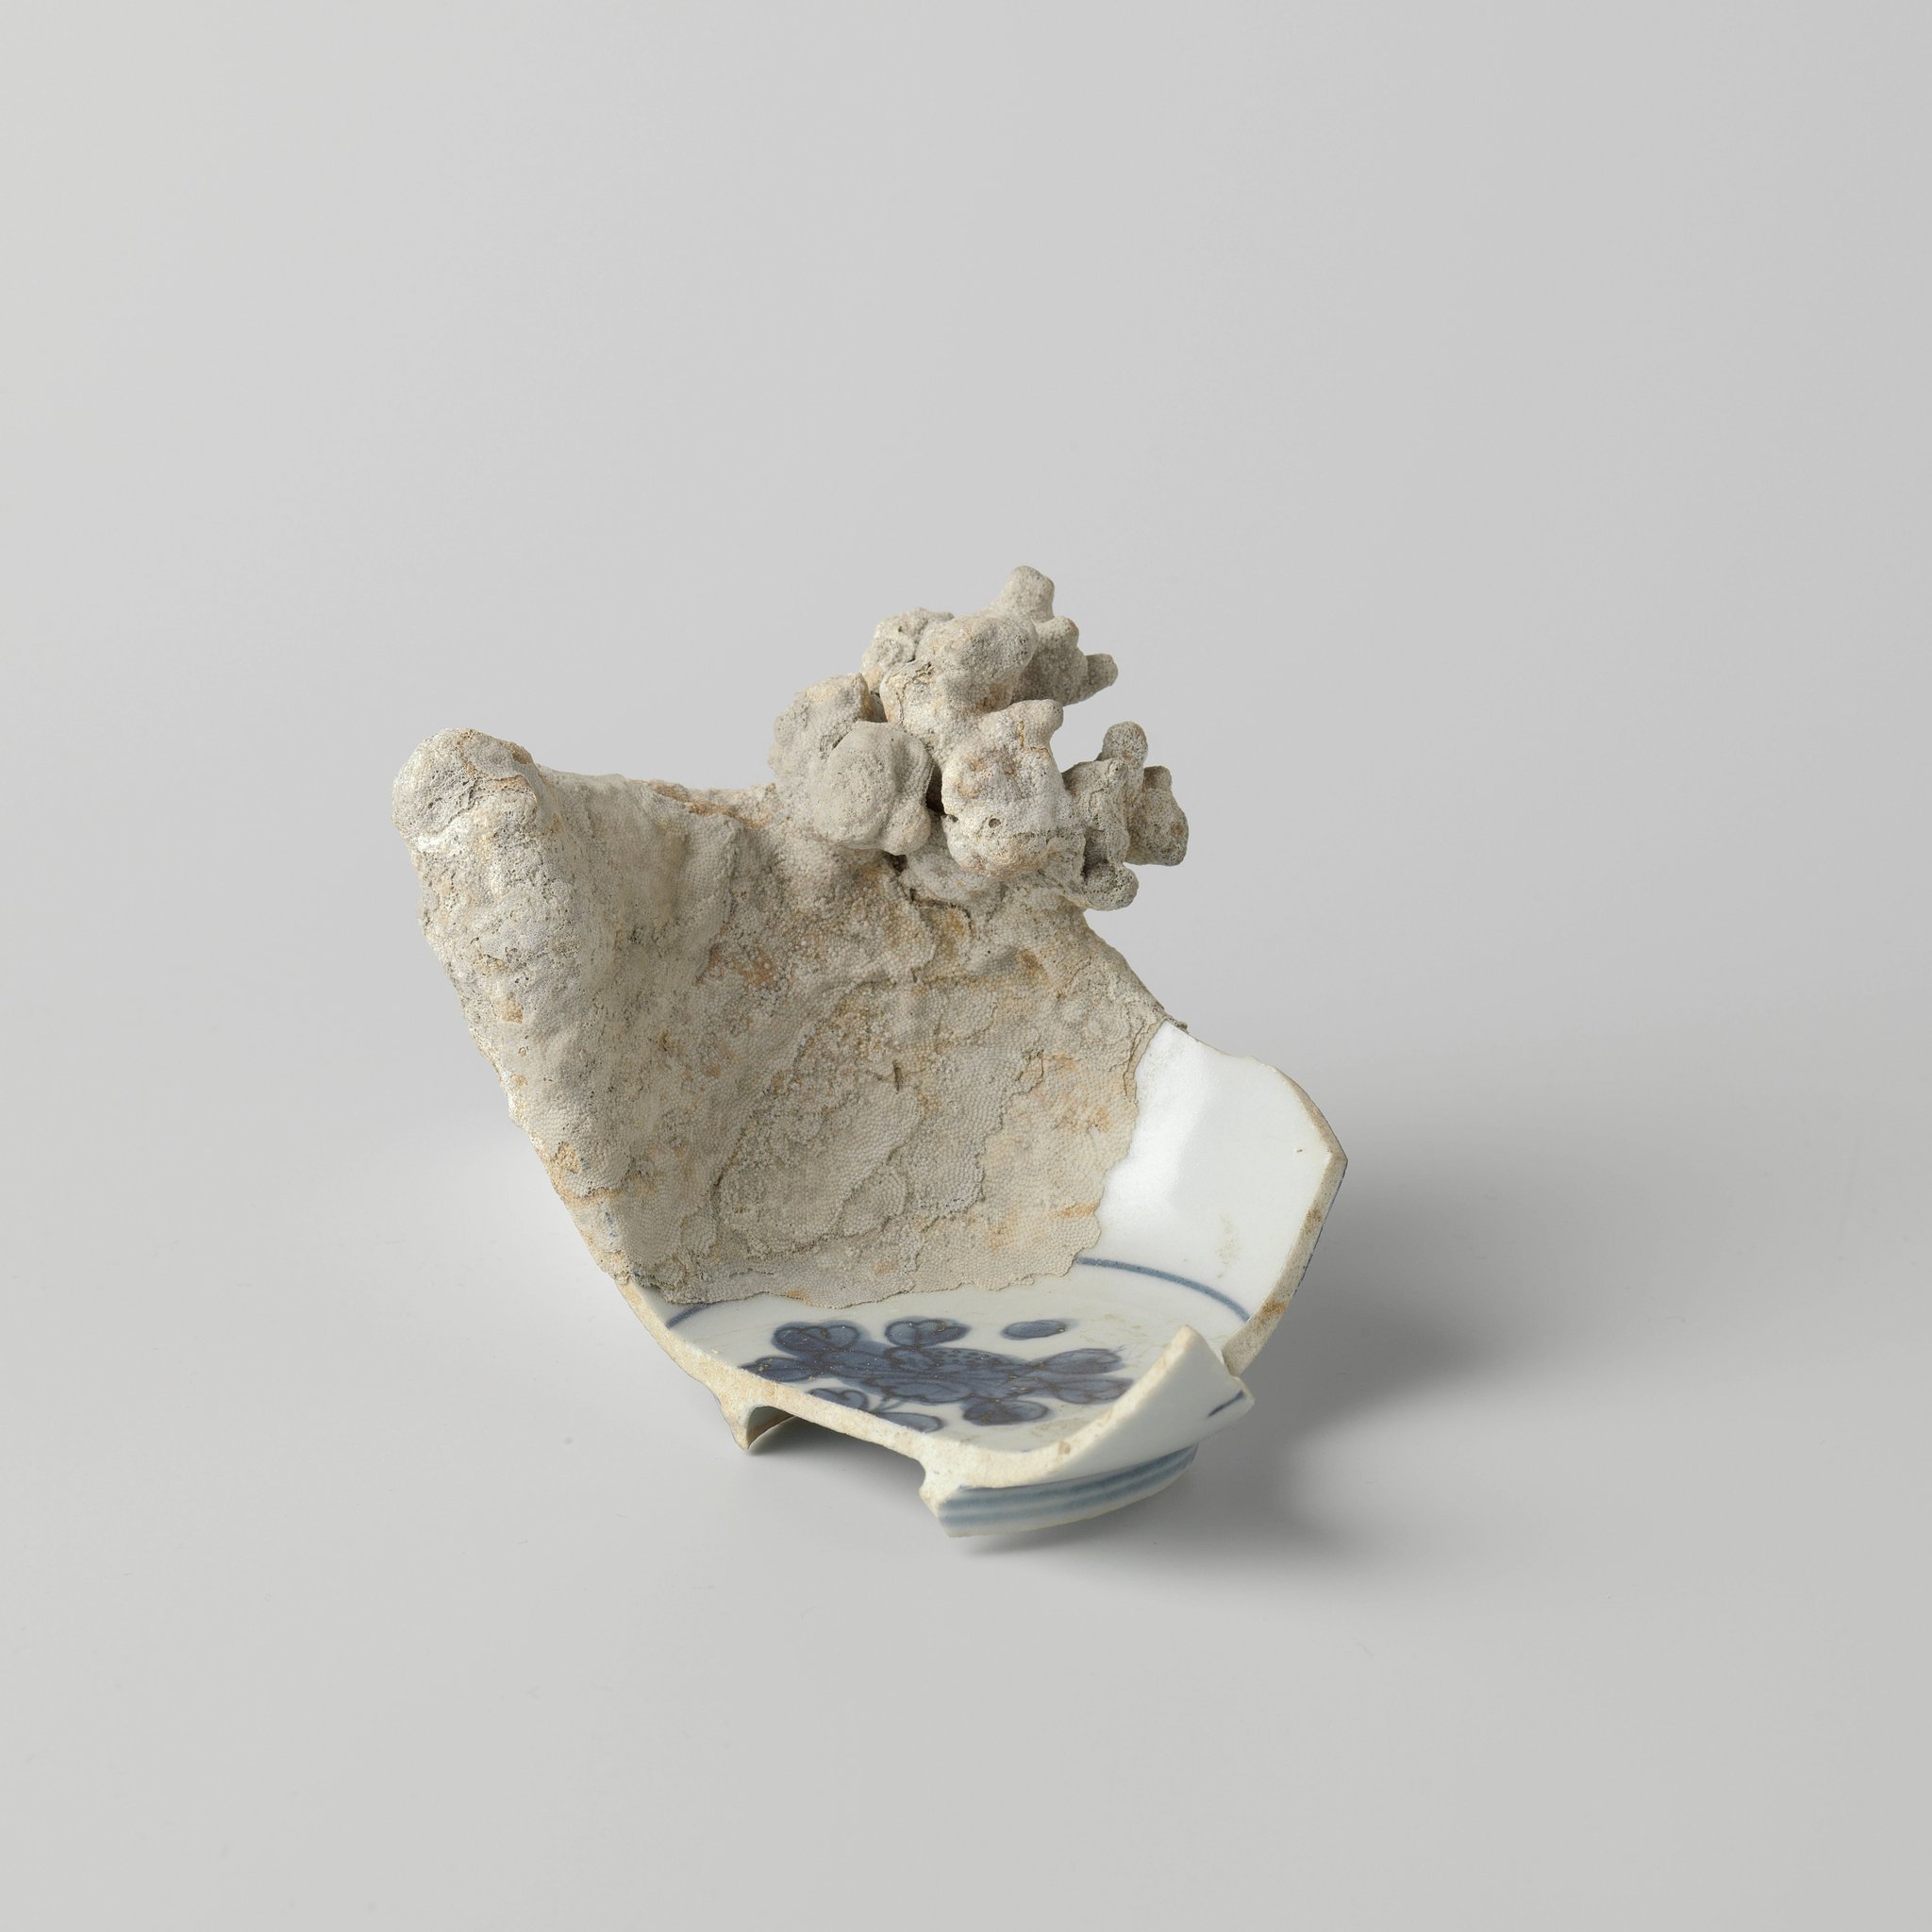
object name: bowl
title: Kom uit V.O.C.-schip de 'Witte Leeuw'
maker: Anonymous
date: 1613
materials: porcelain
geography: jingdezhen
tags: verenigde oostindische compagnie, sint-helena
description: A bowl with encrustation. The bottom is glazed with spiral marks visible. A six-character mark, hand-written in underglaze blue: ta ming jiajing.